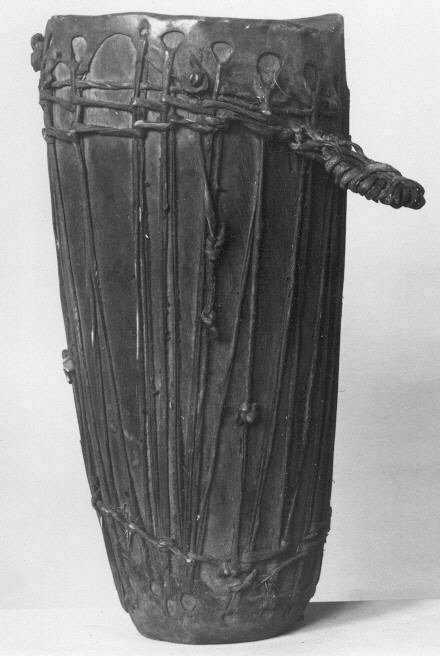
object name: hol drum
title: Hol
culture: indian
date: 1867-1900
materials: cord, skin, wood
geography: india